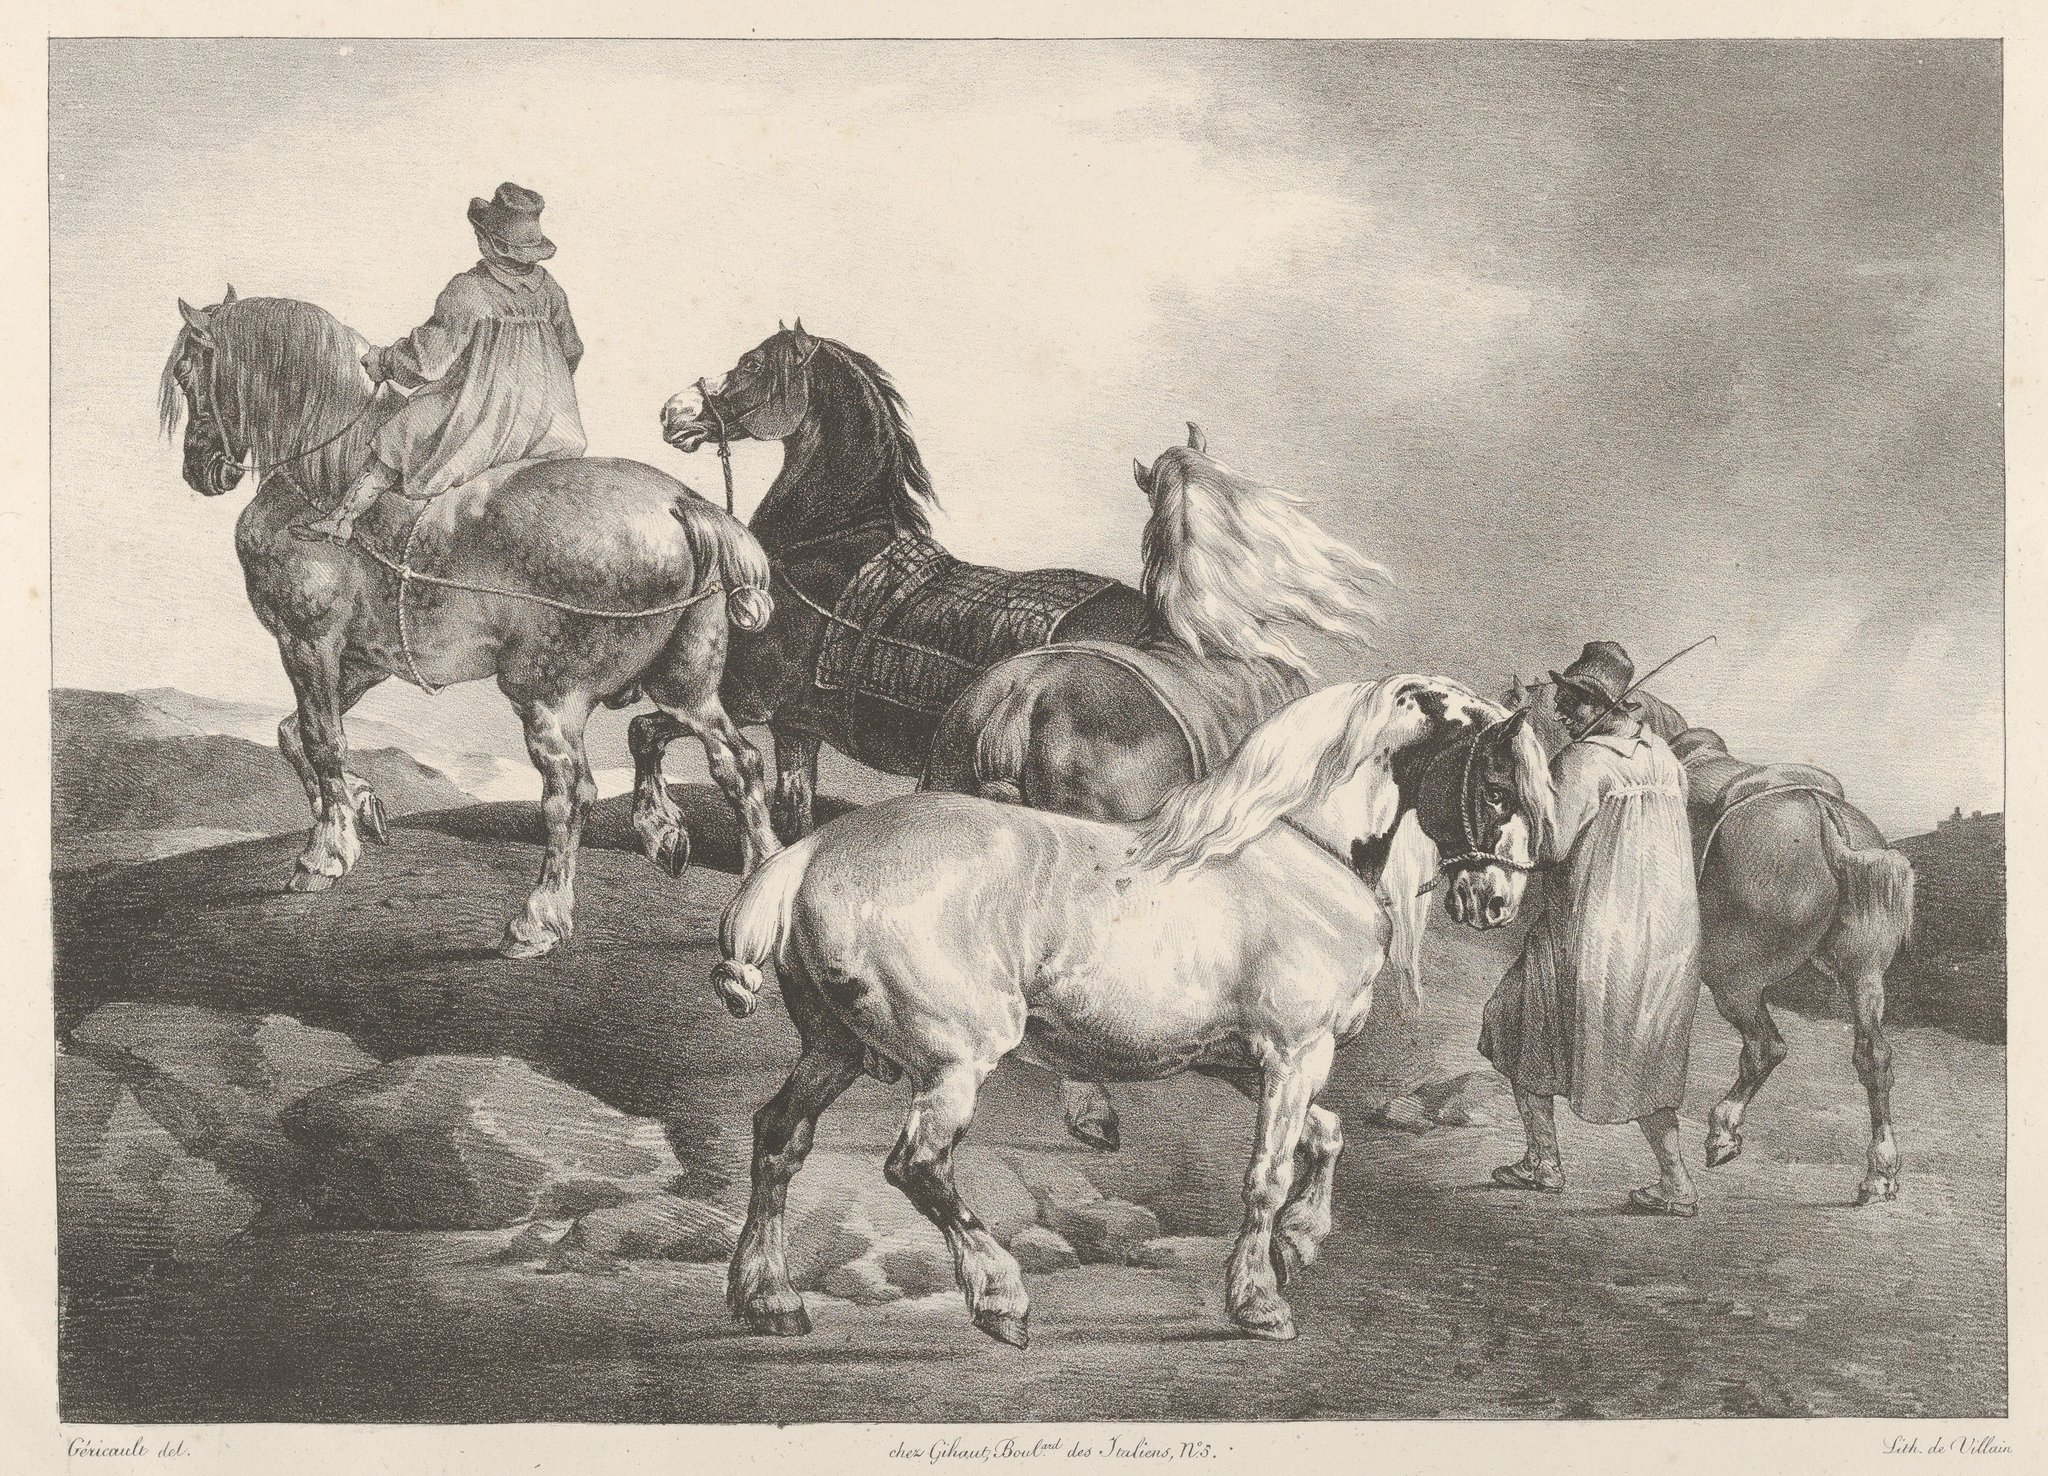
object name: print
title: Horses Driven to a Fair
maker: jean louis andré théodore géricault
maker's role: artist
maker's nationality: french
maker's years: 1791-1824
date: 1822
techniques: lithograph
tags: horses